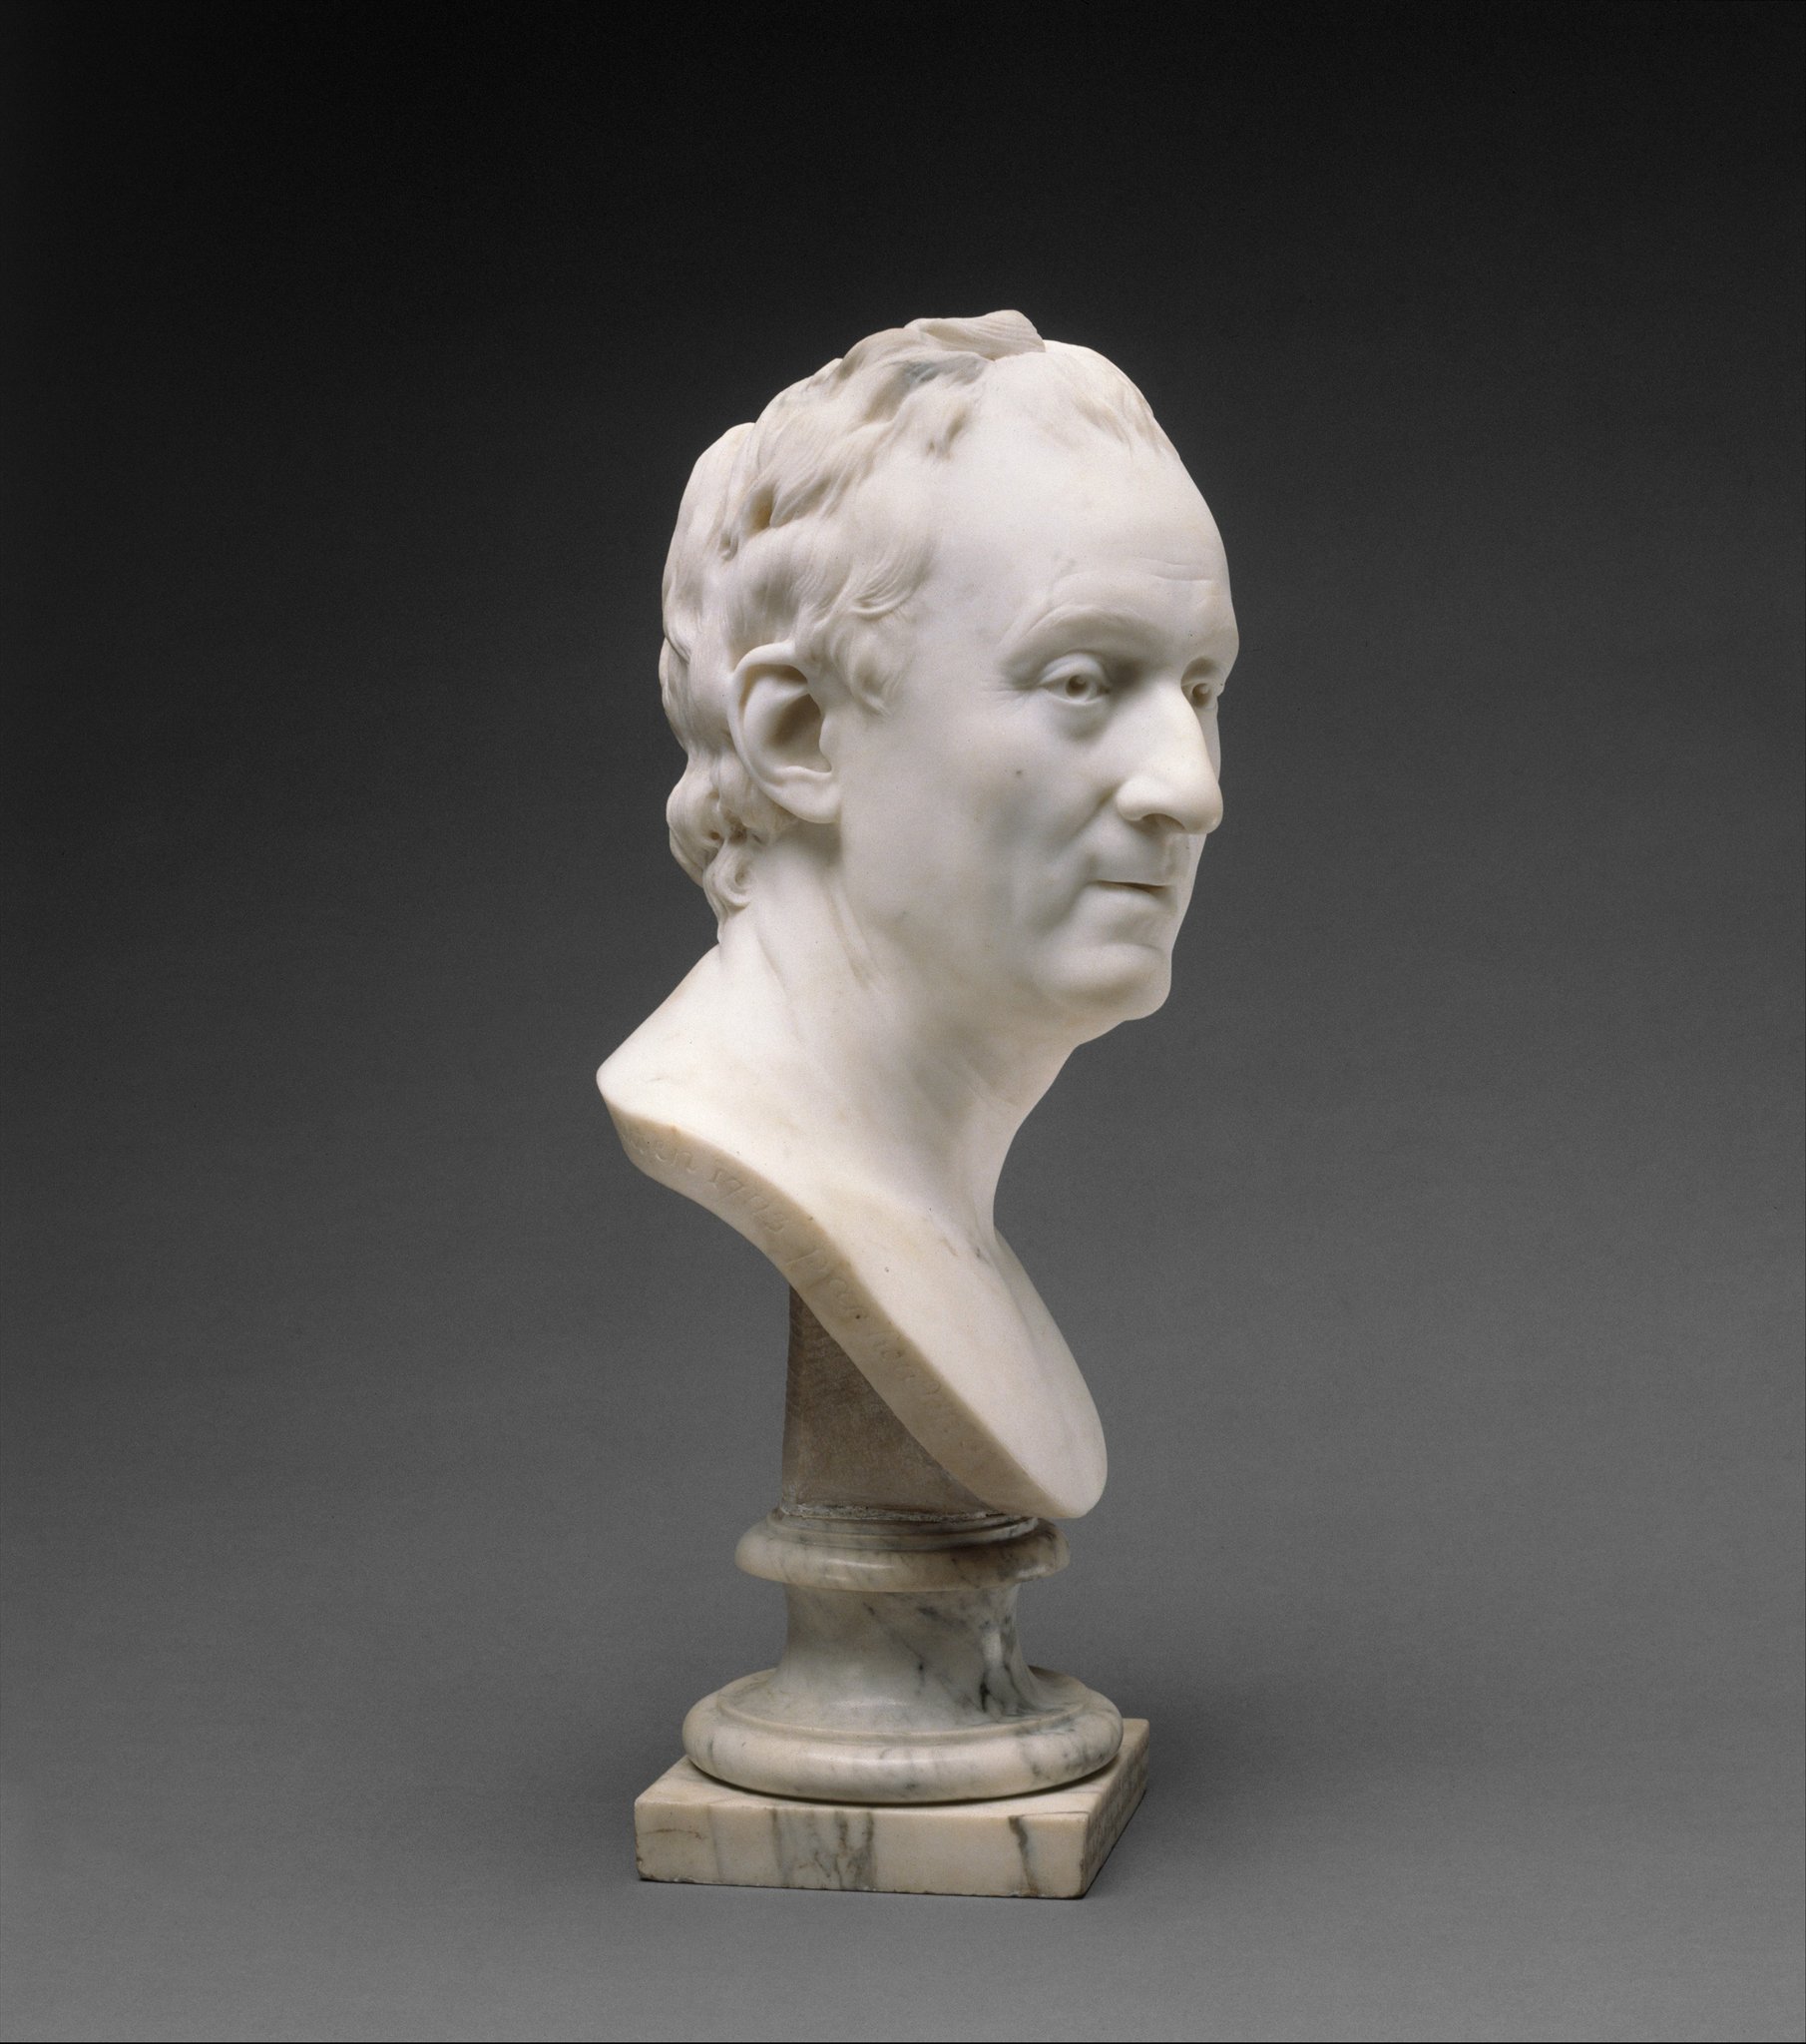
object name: bust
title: Denis Diderot (1713–1784)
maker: jean antoine houdon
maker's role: artist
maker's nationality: french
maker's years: 1741-1828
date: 1773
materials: marble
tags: men,portraits,authors